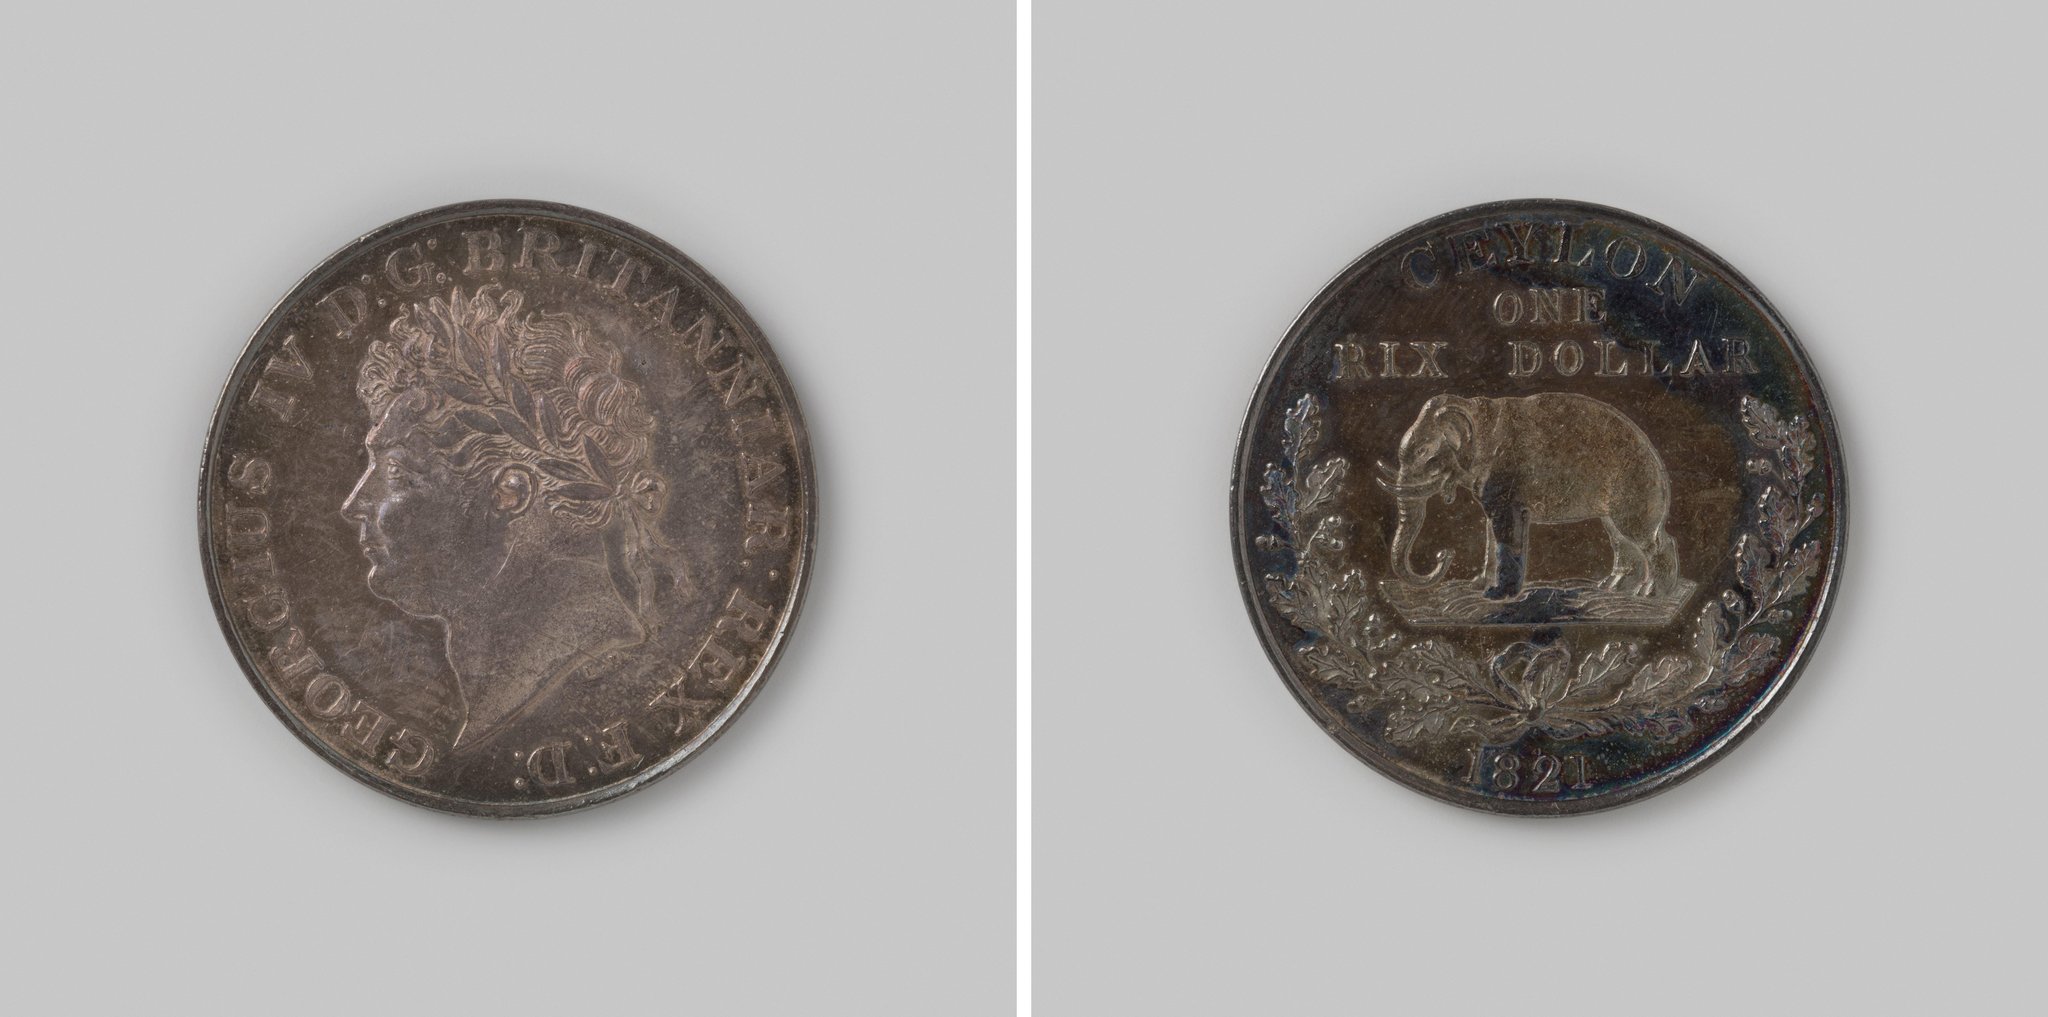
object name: coin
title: Rixdollar van Sri Lanka, Ceylon op naam van koning George IV, 1821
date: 1821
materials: silver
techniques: striking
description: Zilveren munt. Voorzijde: gelauwerd borstbeeld van de koning naar links. Keerzijde: tussen twee samengebonden takken lopende olifant naar links. Daarboven in twee regels waarde-aanduiding: one rix dollar. Jaartal onderaan. Gladde rand. Geslagen in Engeland.